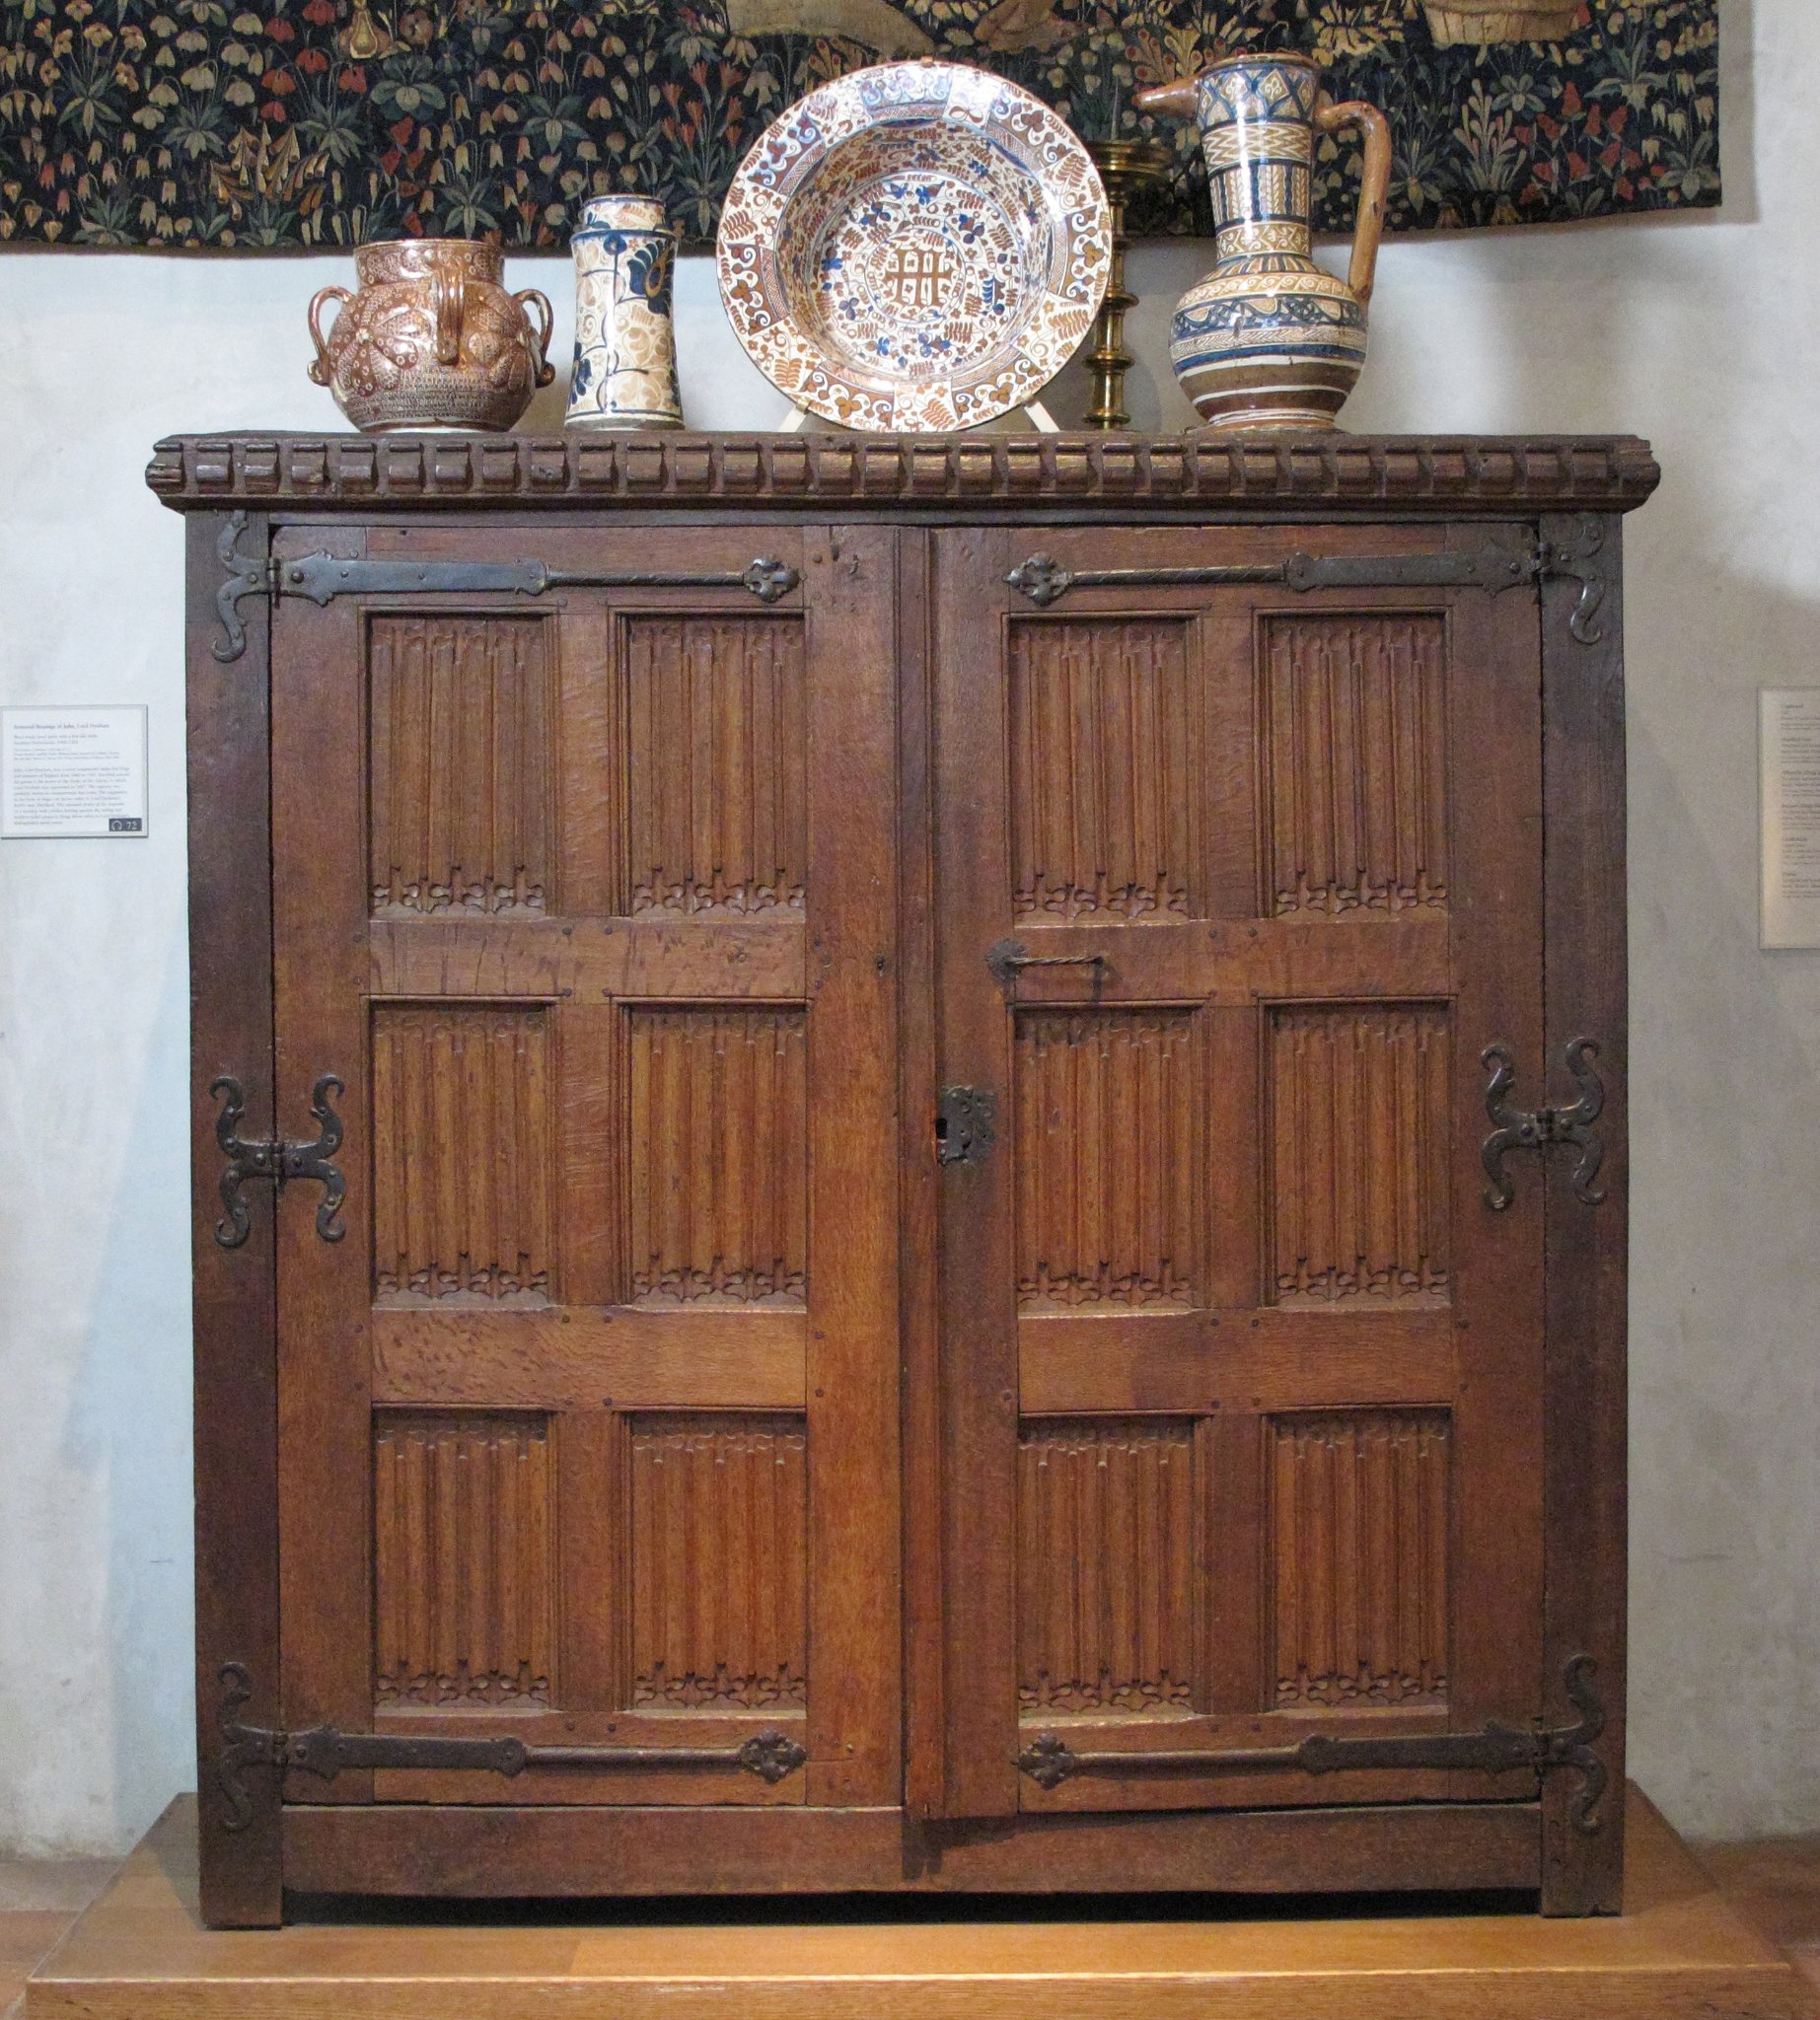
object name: cabinet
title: Cupboard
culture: french or south netherlandish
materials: wood